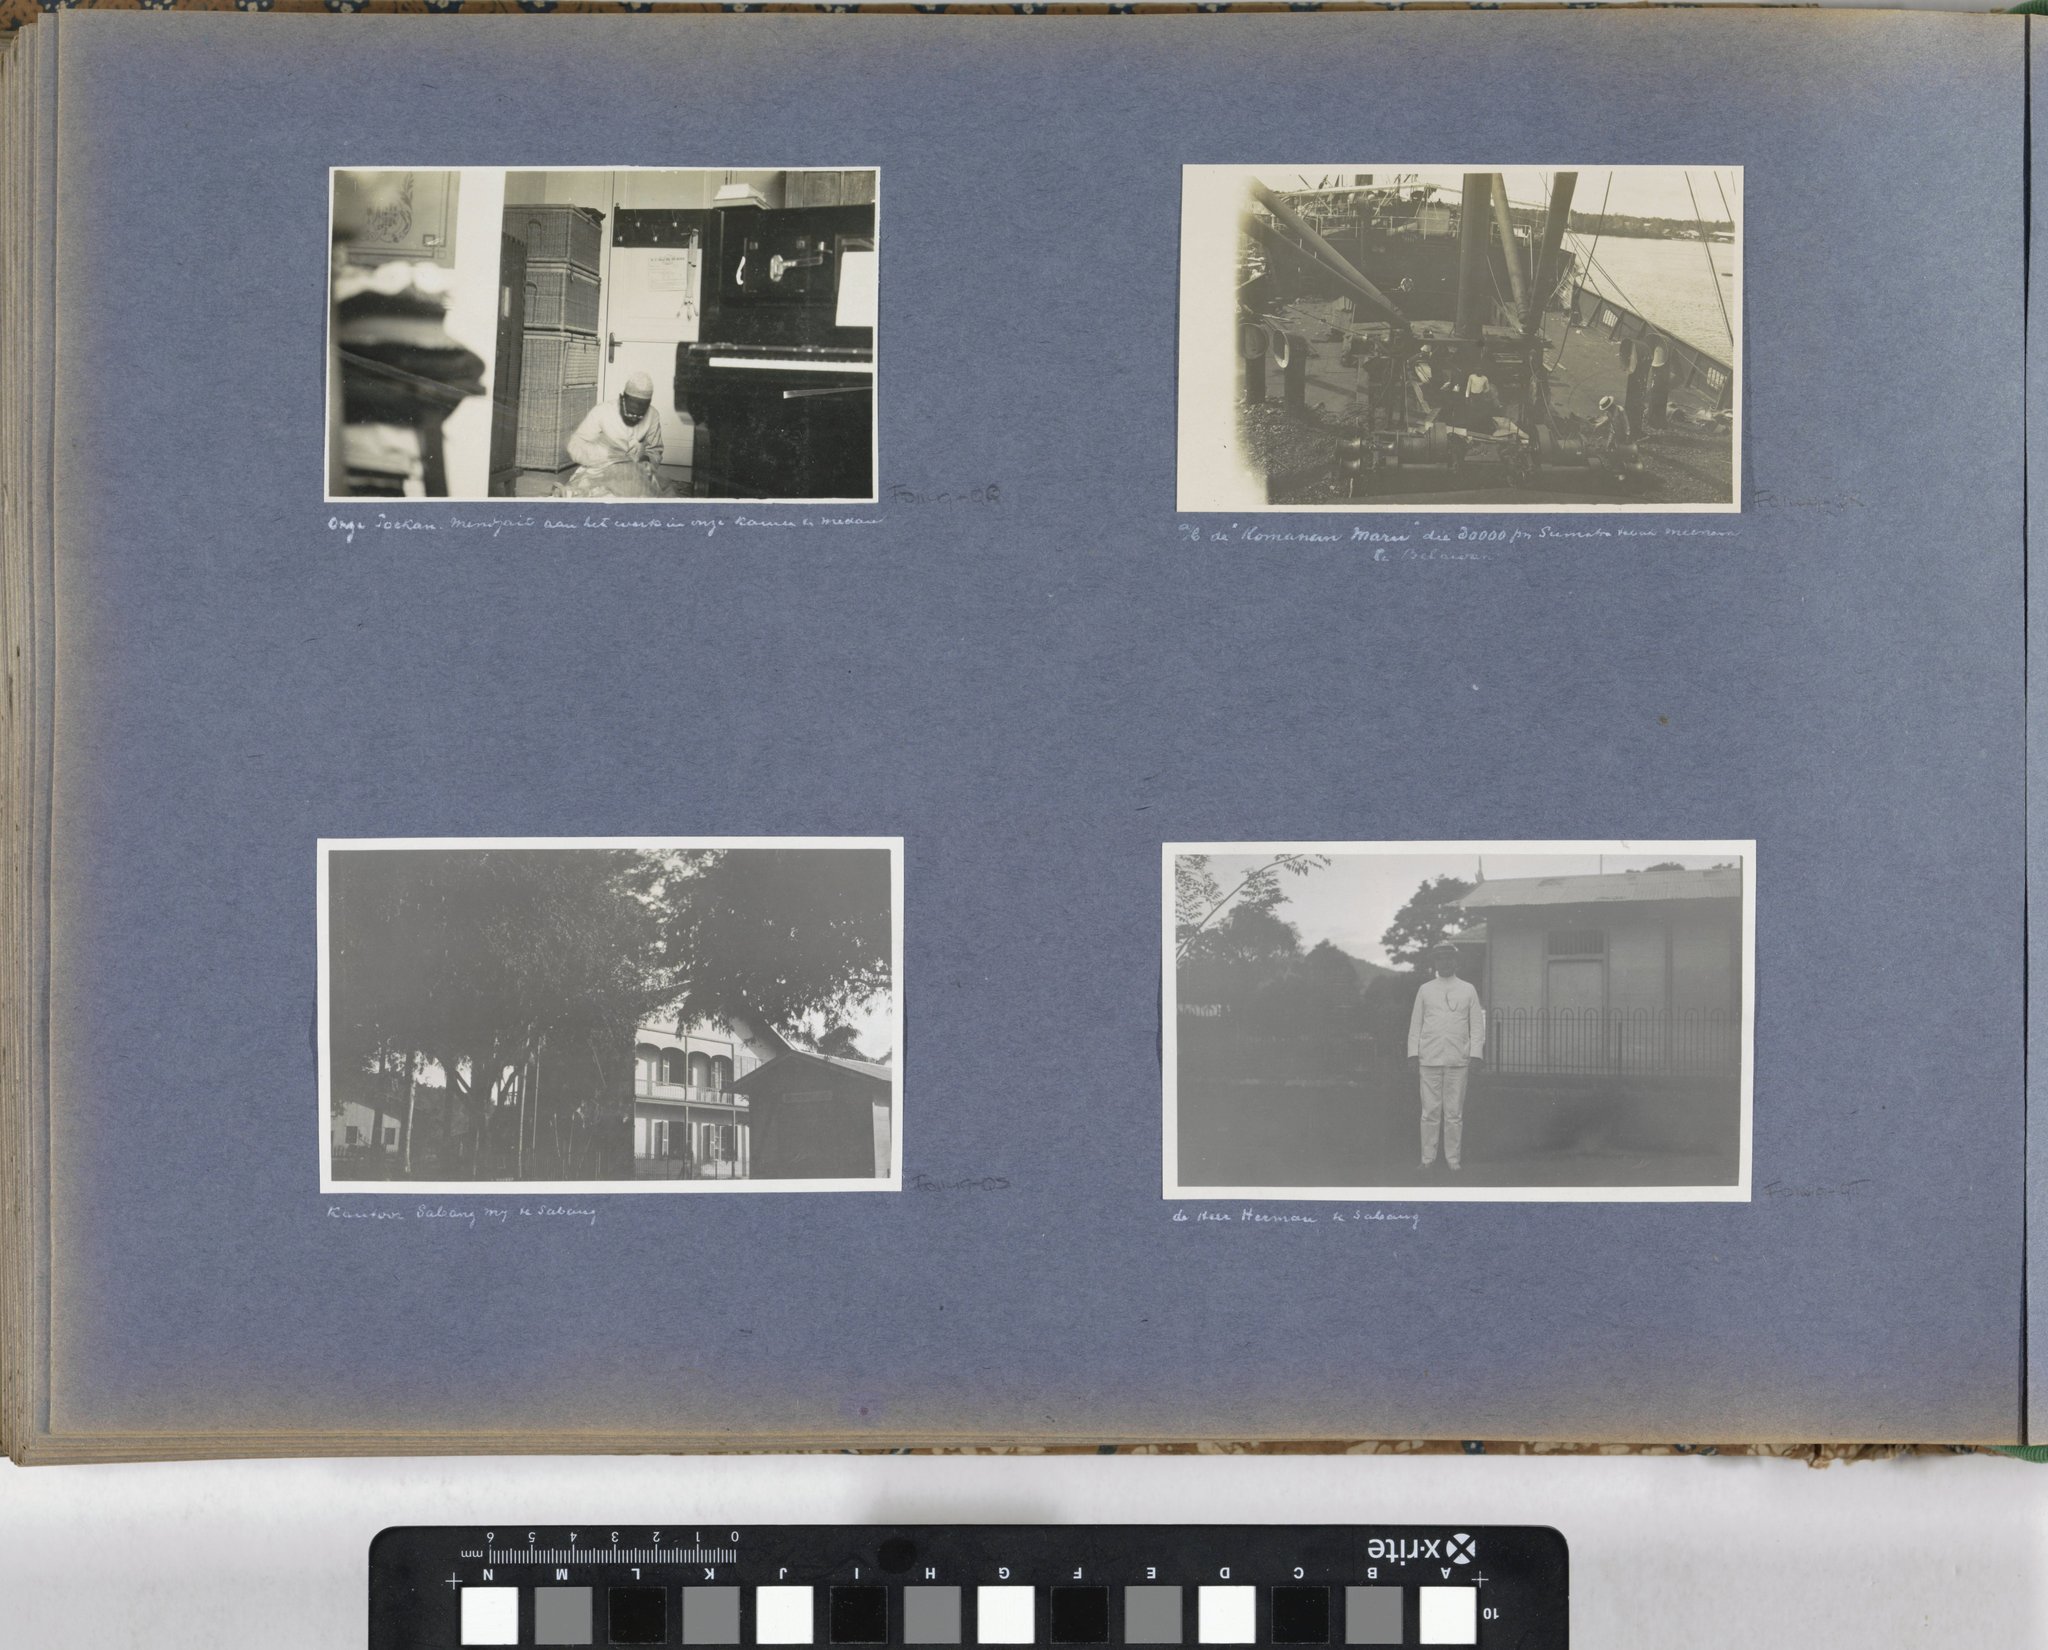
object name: photograph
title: Onze Toekan mendjait aan het werk in onze kamer in Medan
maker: Anonymous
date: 1900-1920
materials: paper, photographic support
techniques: gelatin silver print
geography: medan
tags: hotel, hostelry, inn, kitchen-personnel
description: Onderdeel van reisalbum met foto's van bedrijvigheid en bezienswaardigheden op Sumatra en Java en van de reis naar en van Nederlands-Indië.